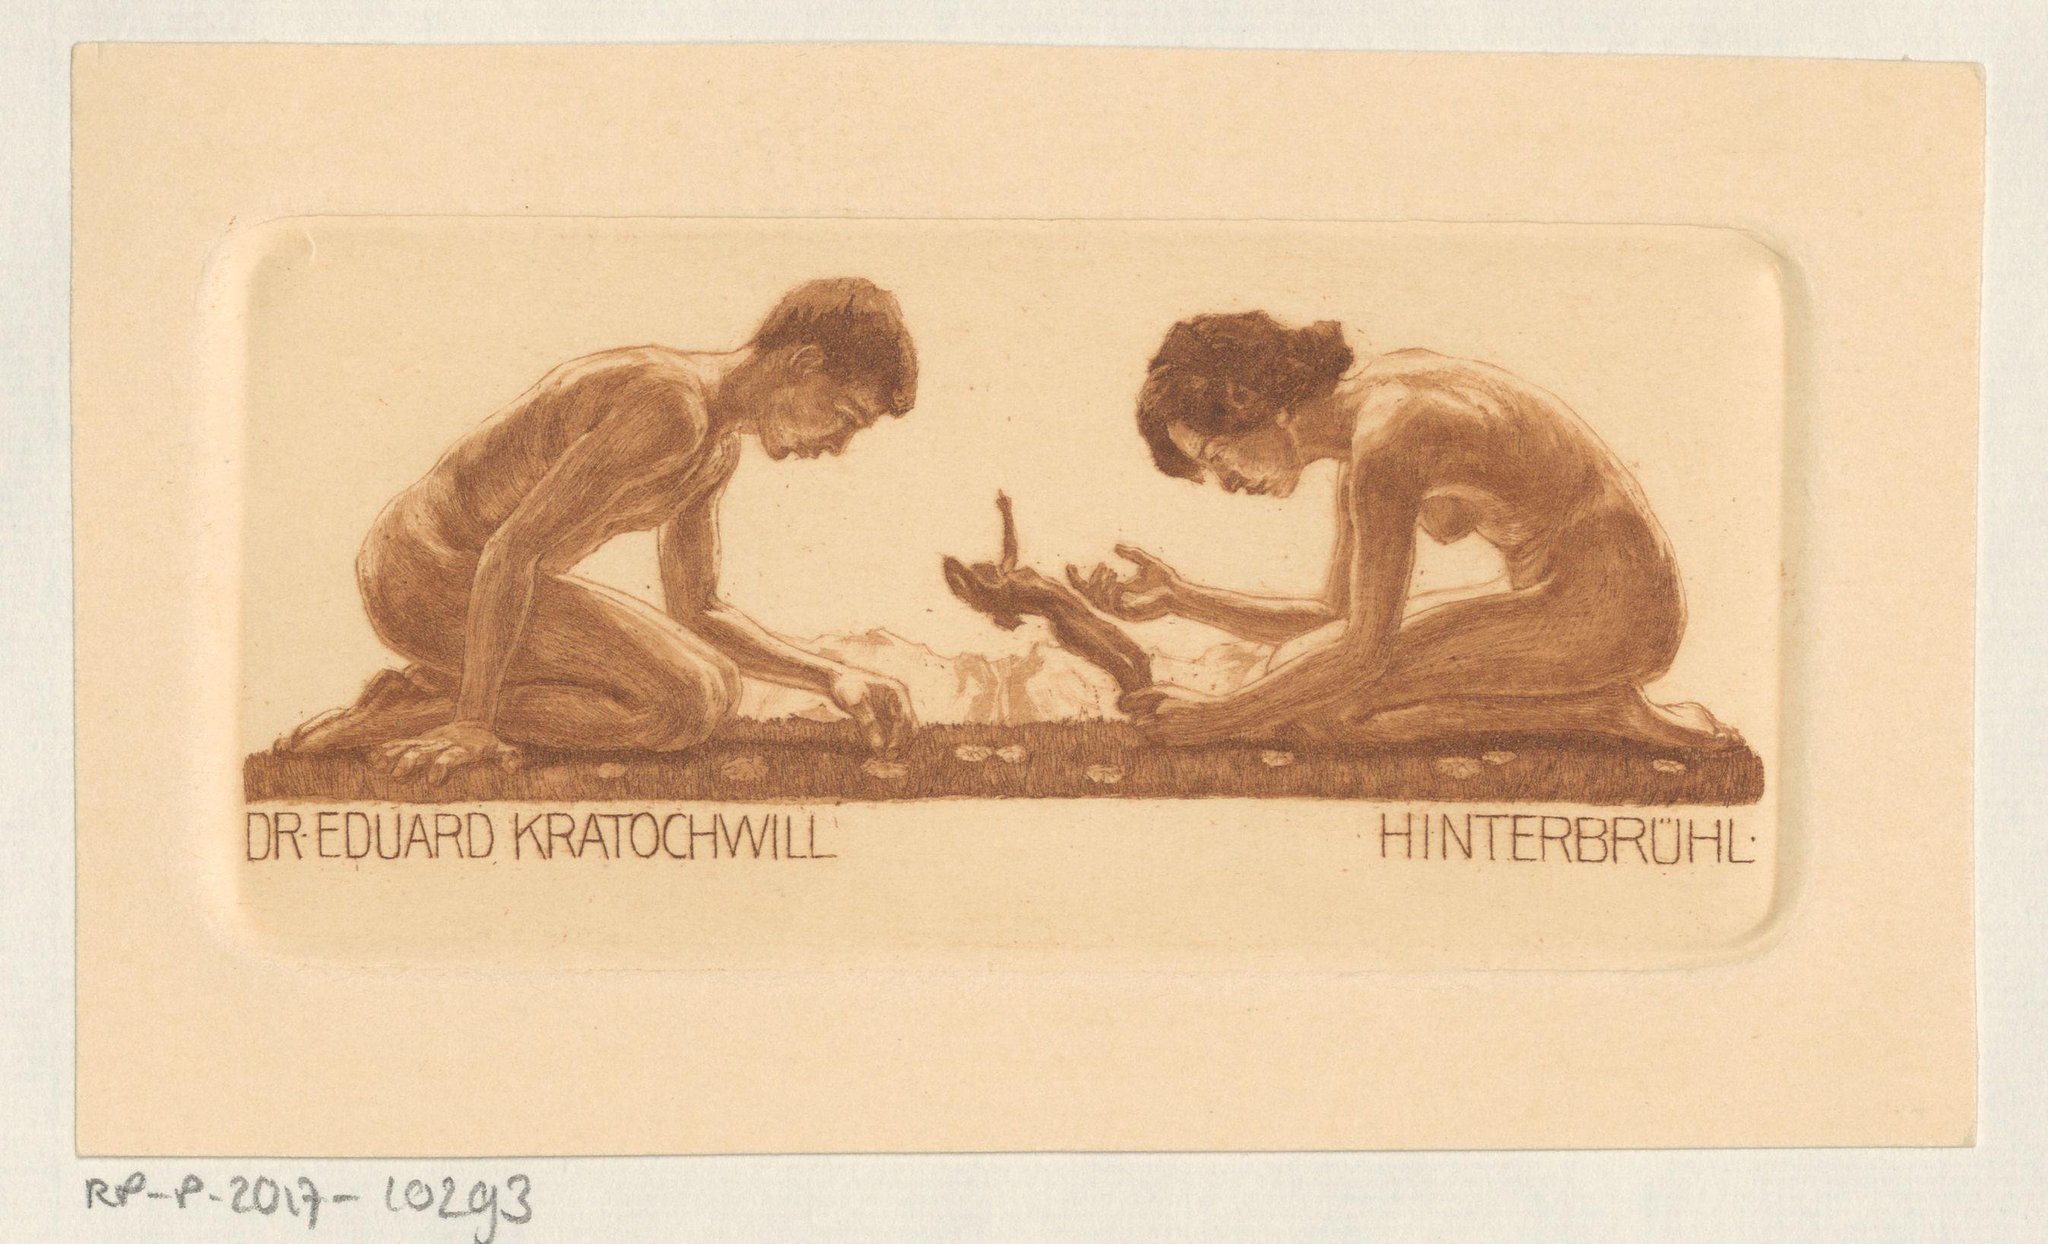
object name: bookplate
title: Ex libris van Eduard Kratochwill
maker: Anonymous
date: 1880-1949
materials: paper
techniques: aquatint, etching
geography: germany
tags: woman (showing herself) undressed, quasi-nude, sculpture, man (showing himself) undressed, quasi-nude